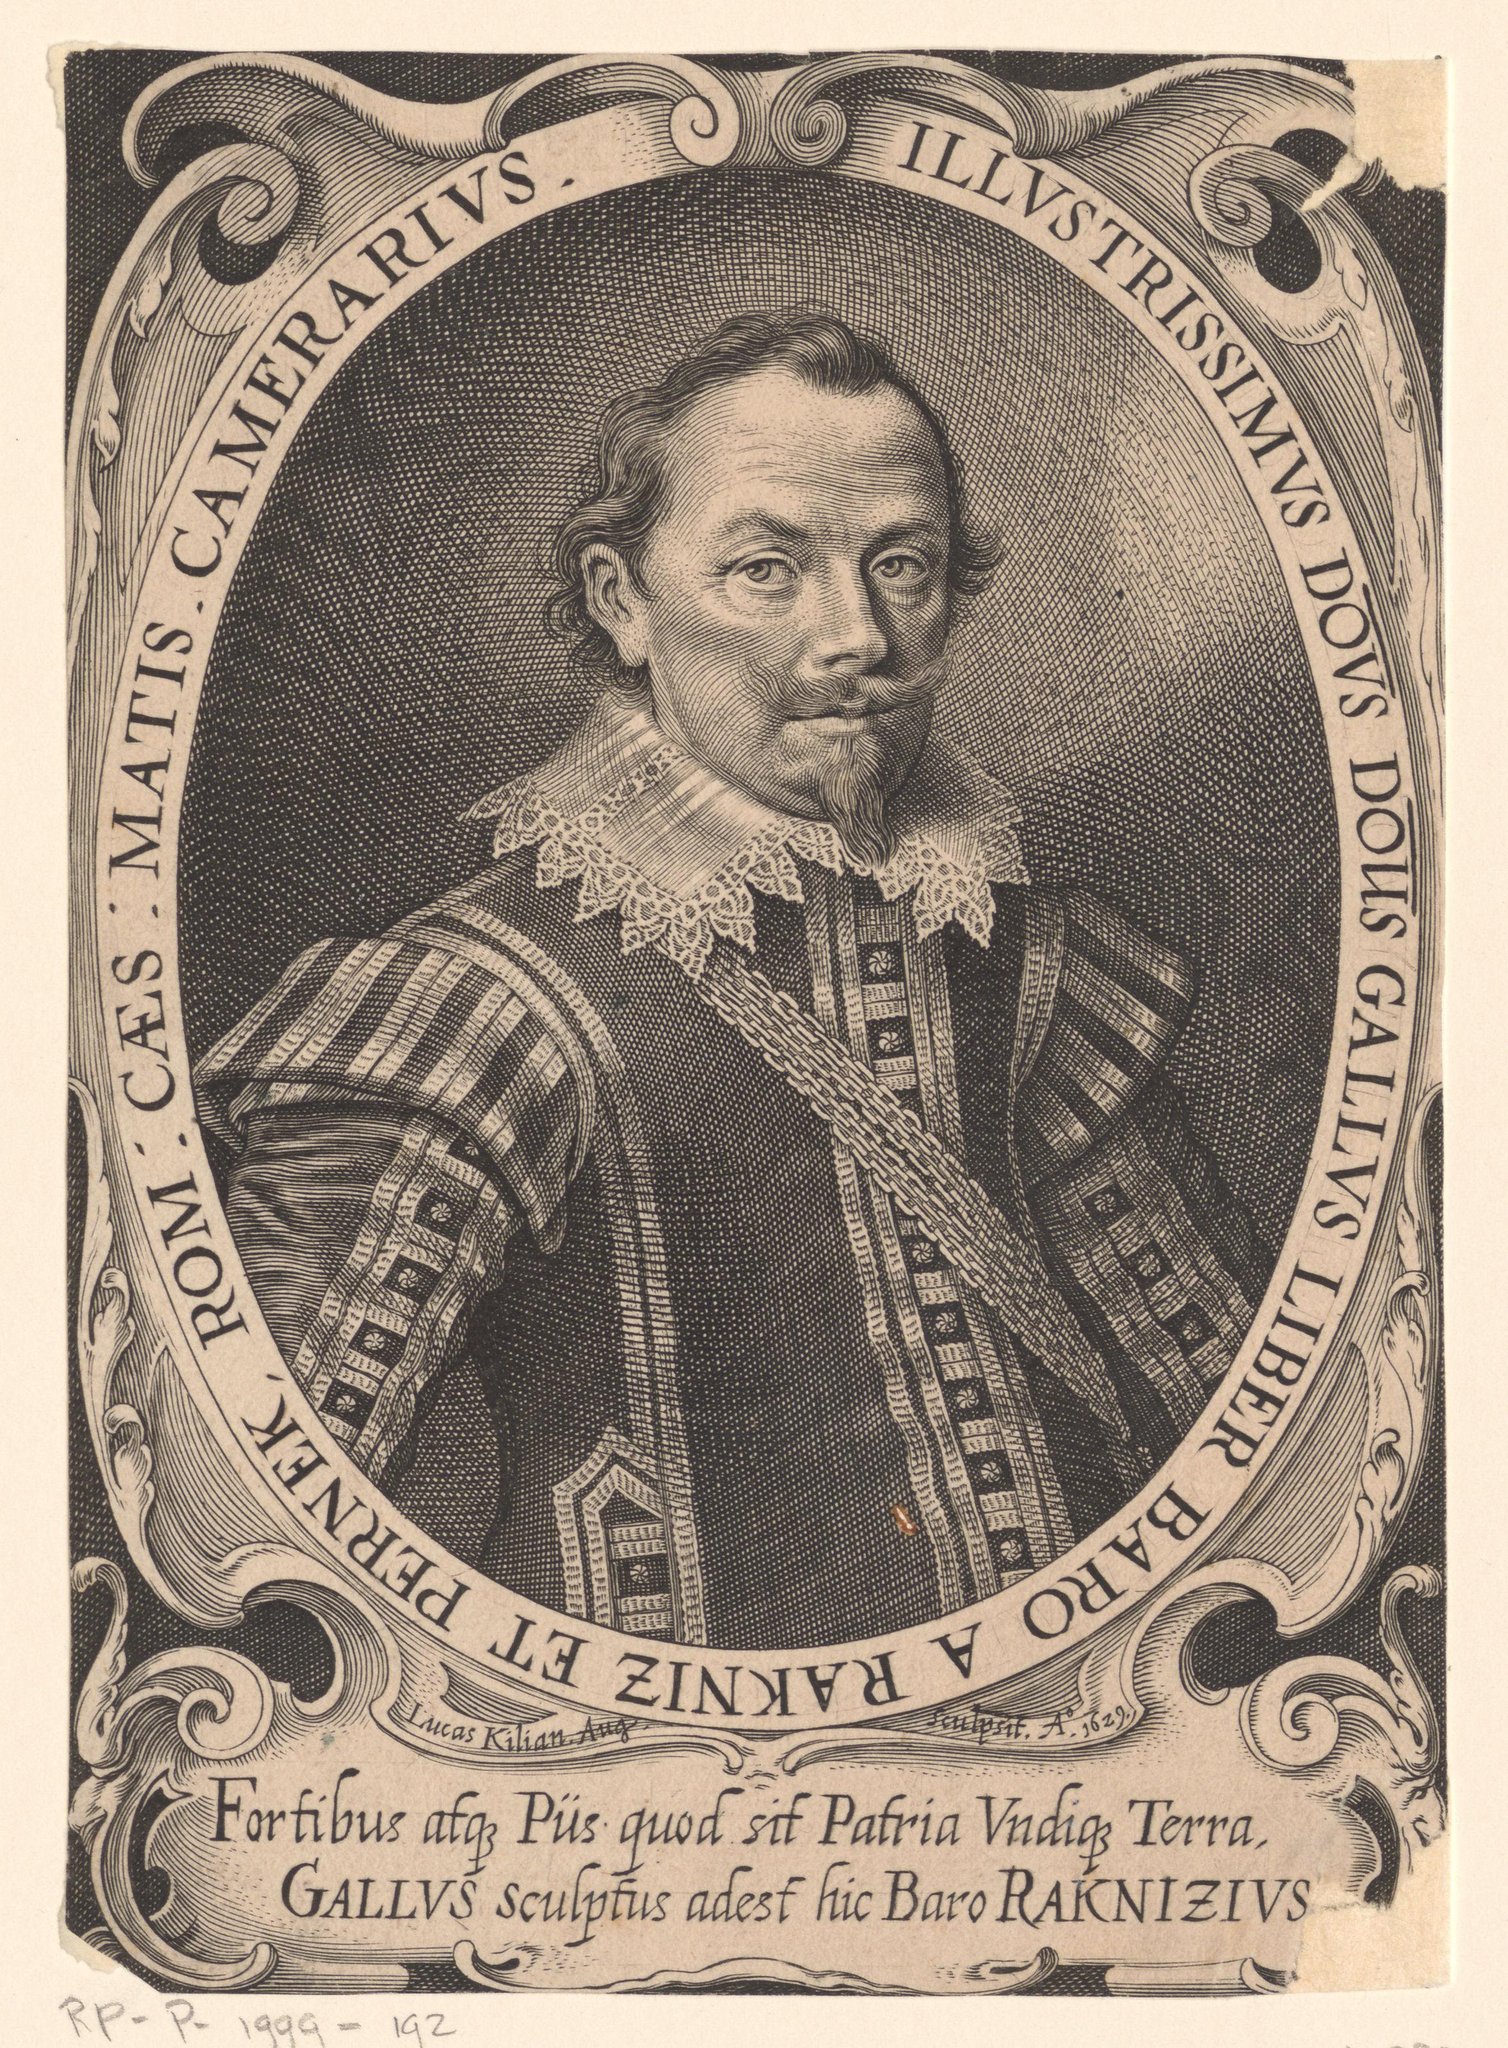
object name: print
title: Portret van Carl Gall von Räcknitz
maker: lucas kilian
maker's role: draughtsman, print maker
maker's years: 1579-1637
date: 1629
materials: paper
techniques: engraving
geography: augsburg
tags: historical persons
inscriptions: collector's mark: Lugt 2760, collector's mark: 2228